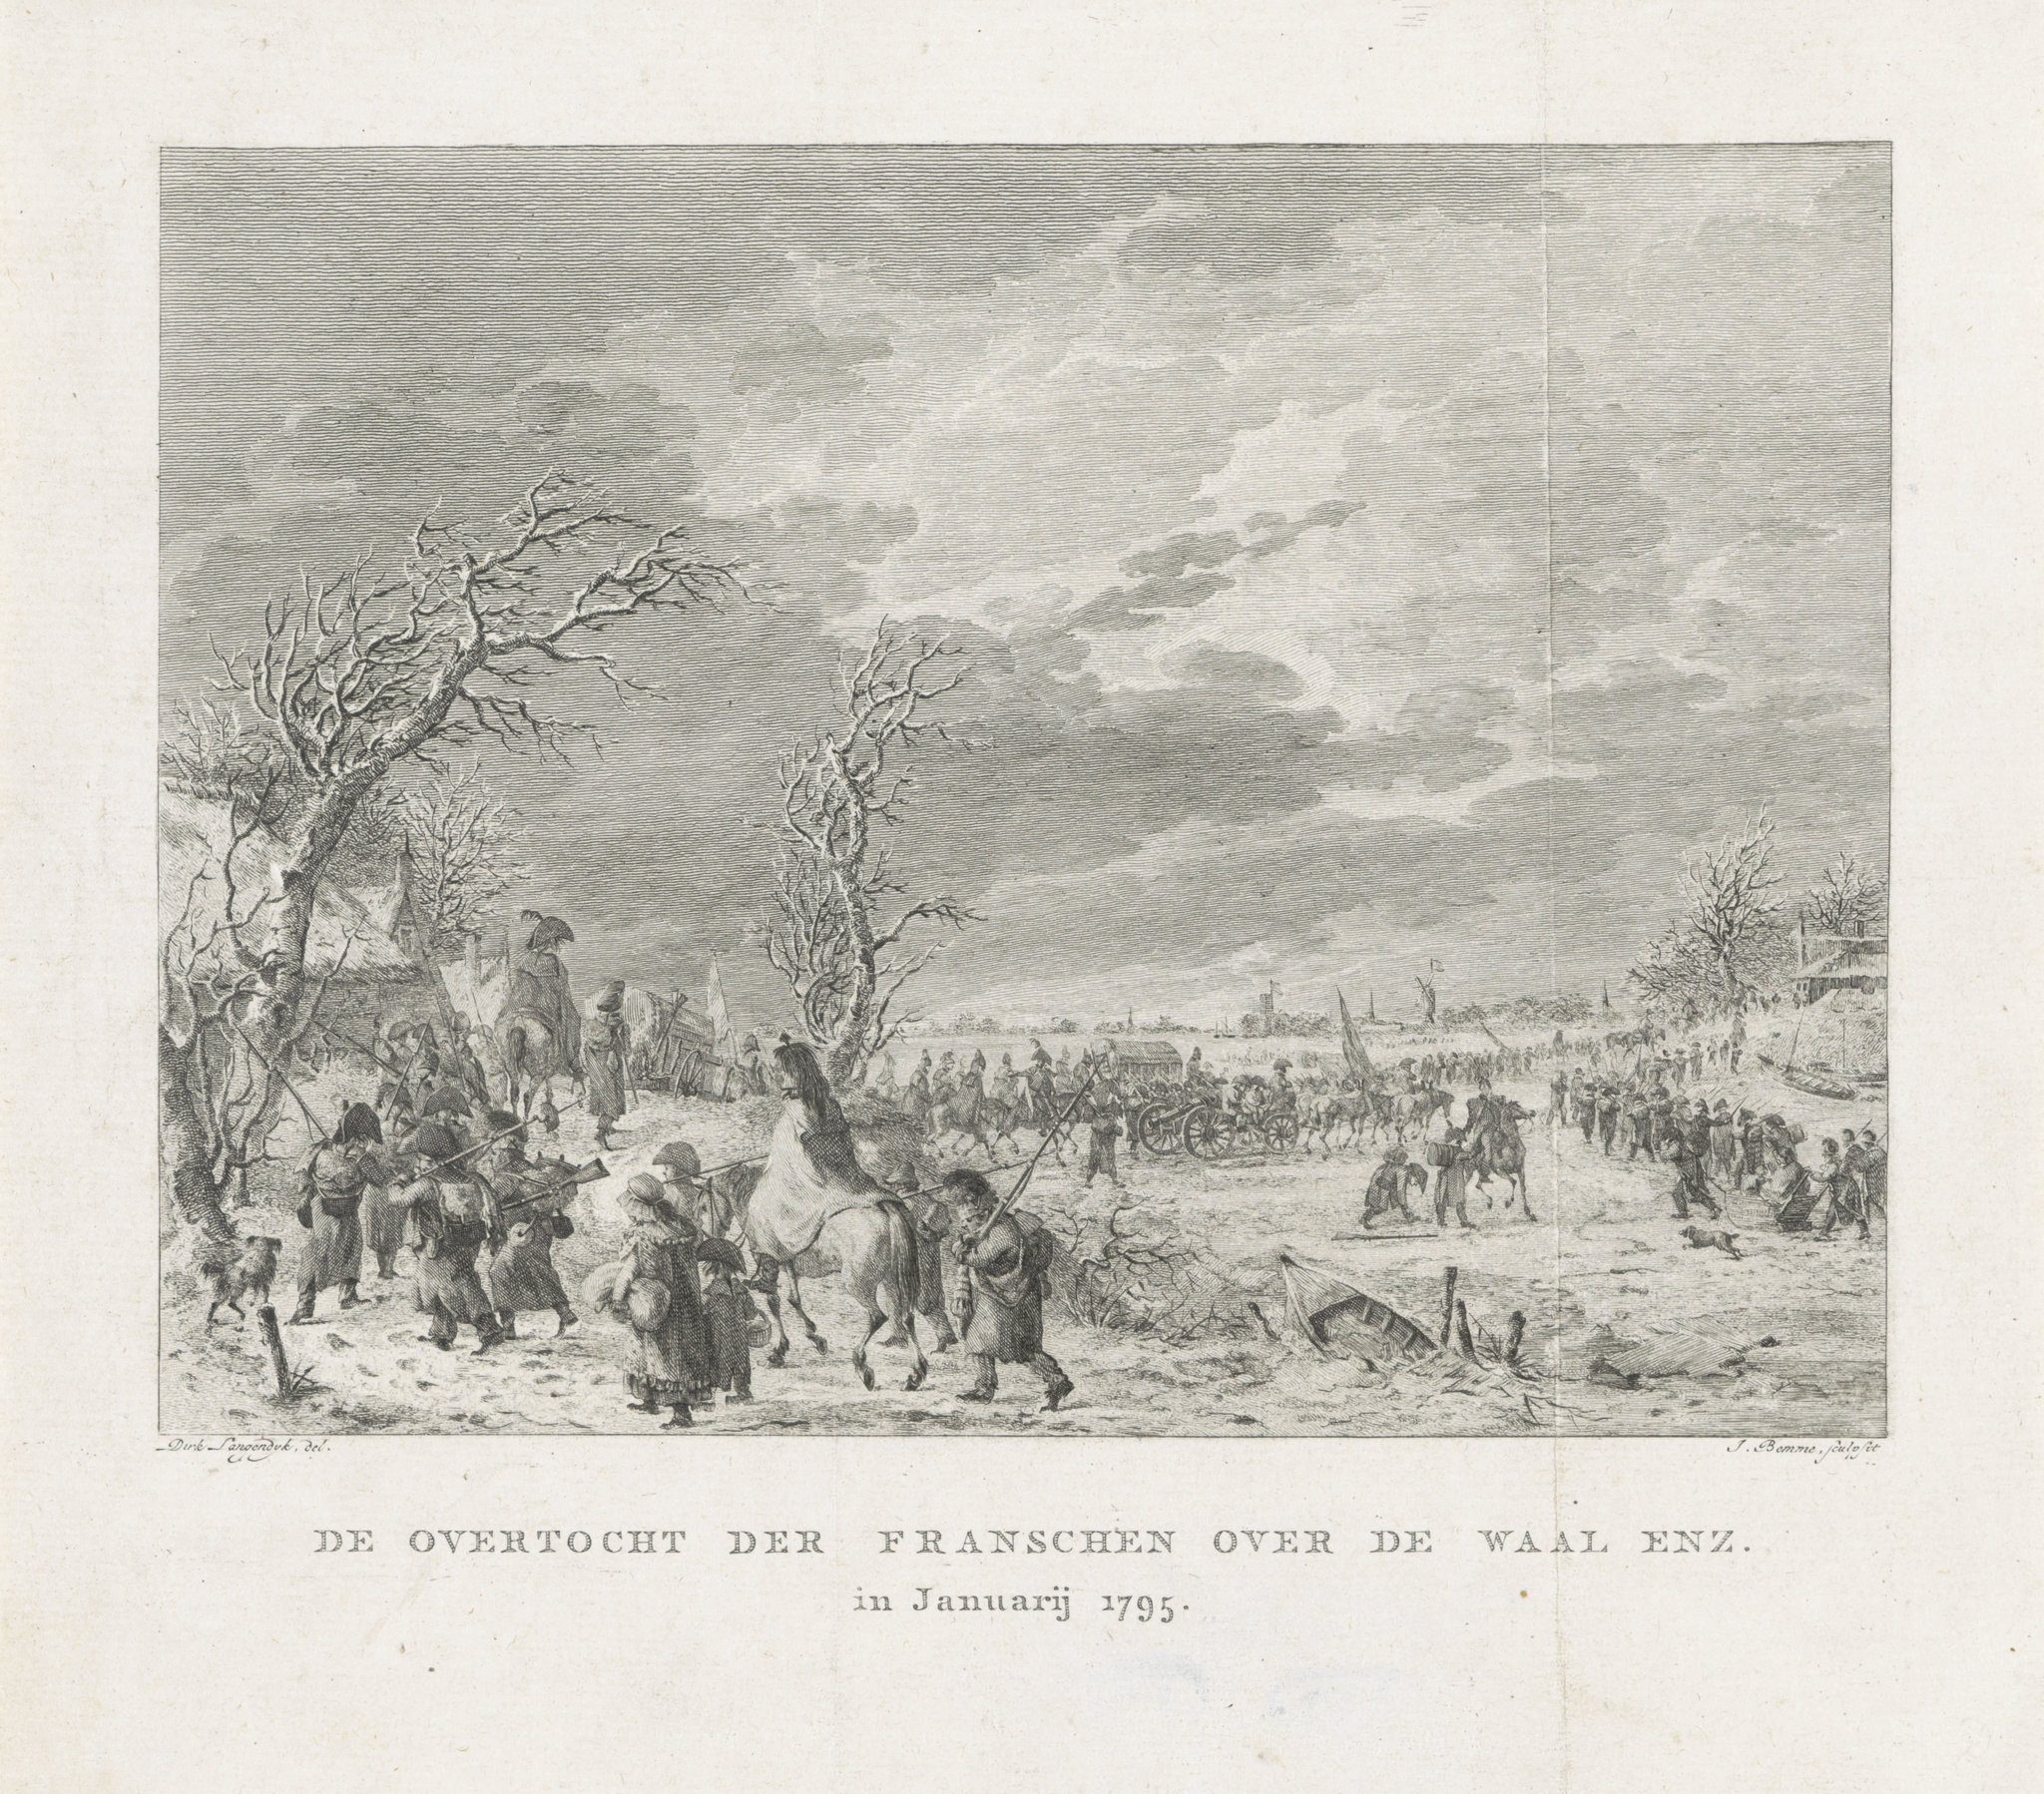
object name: print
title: De Overtocht der Franschen over de Waal enz. in Januarij 1795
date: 1795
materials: paper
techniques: engraving, etching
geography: northern netherlands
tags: paris, politician, jean-charles pichegru, march into the conquered place, transport, train (military) (+ land forces)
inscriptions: collector's mark: Lugt 2228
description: De Franse troepen onder generaal Pichegru steken de bevroren Waal over, januari 1795. De gehavende soldaten steken te voet en te paard de bevroren rivier over. Geschut wordt op wagens mee gevoerd.